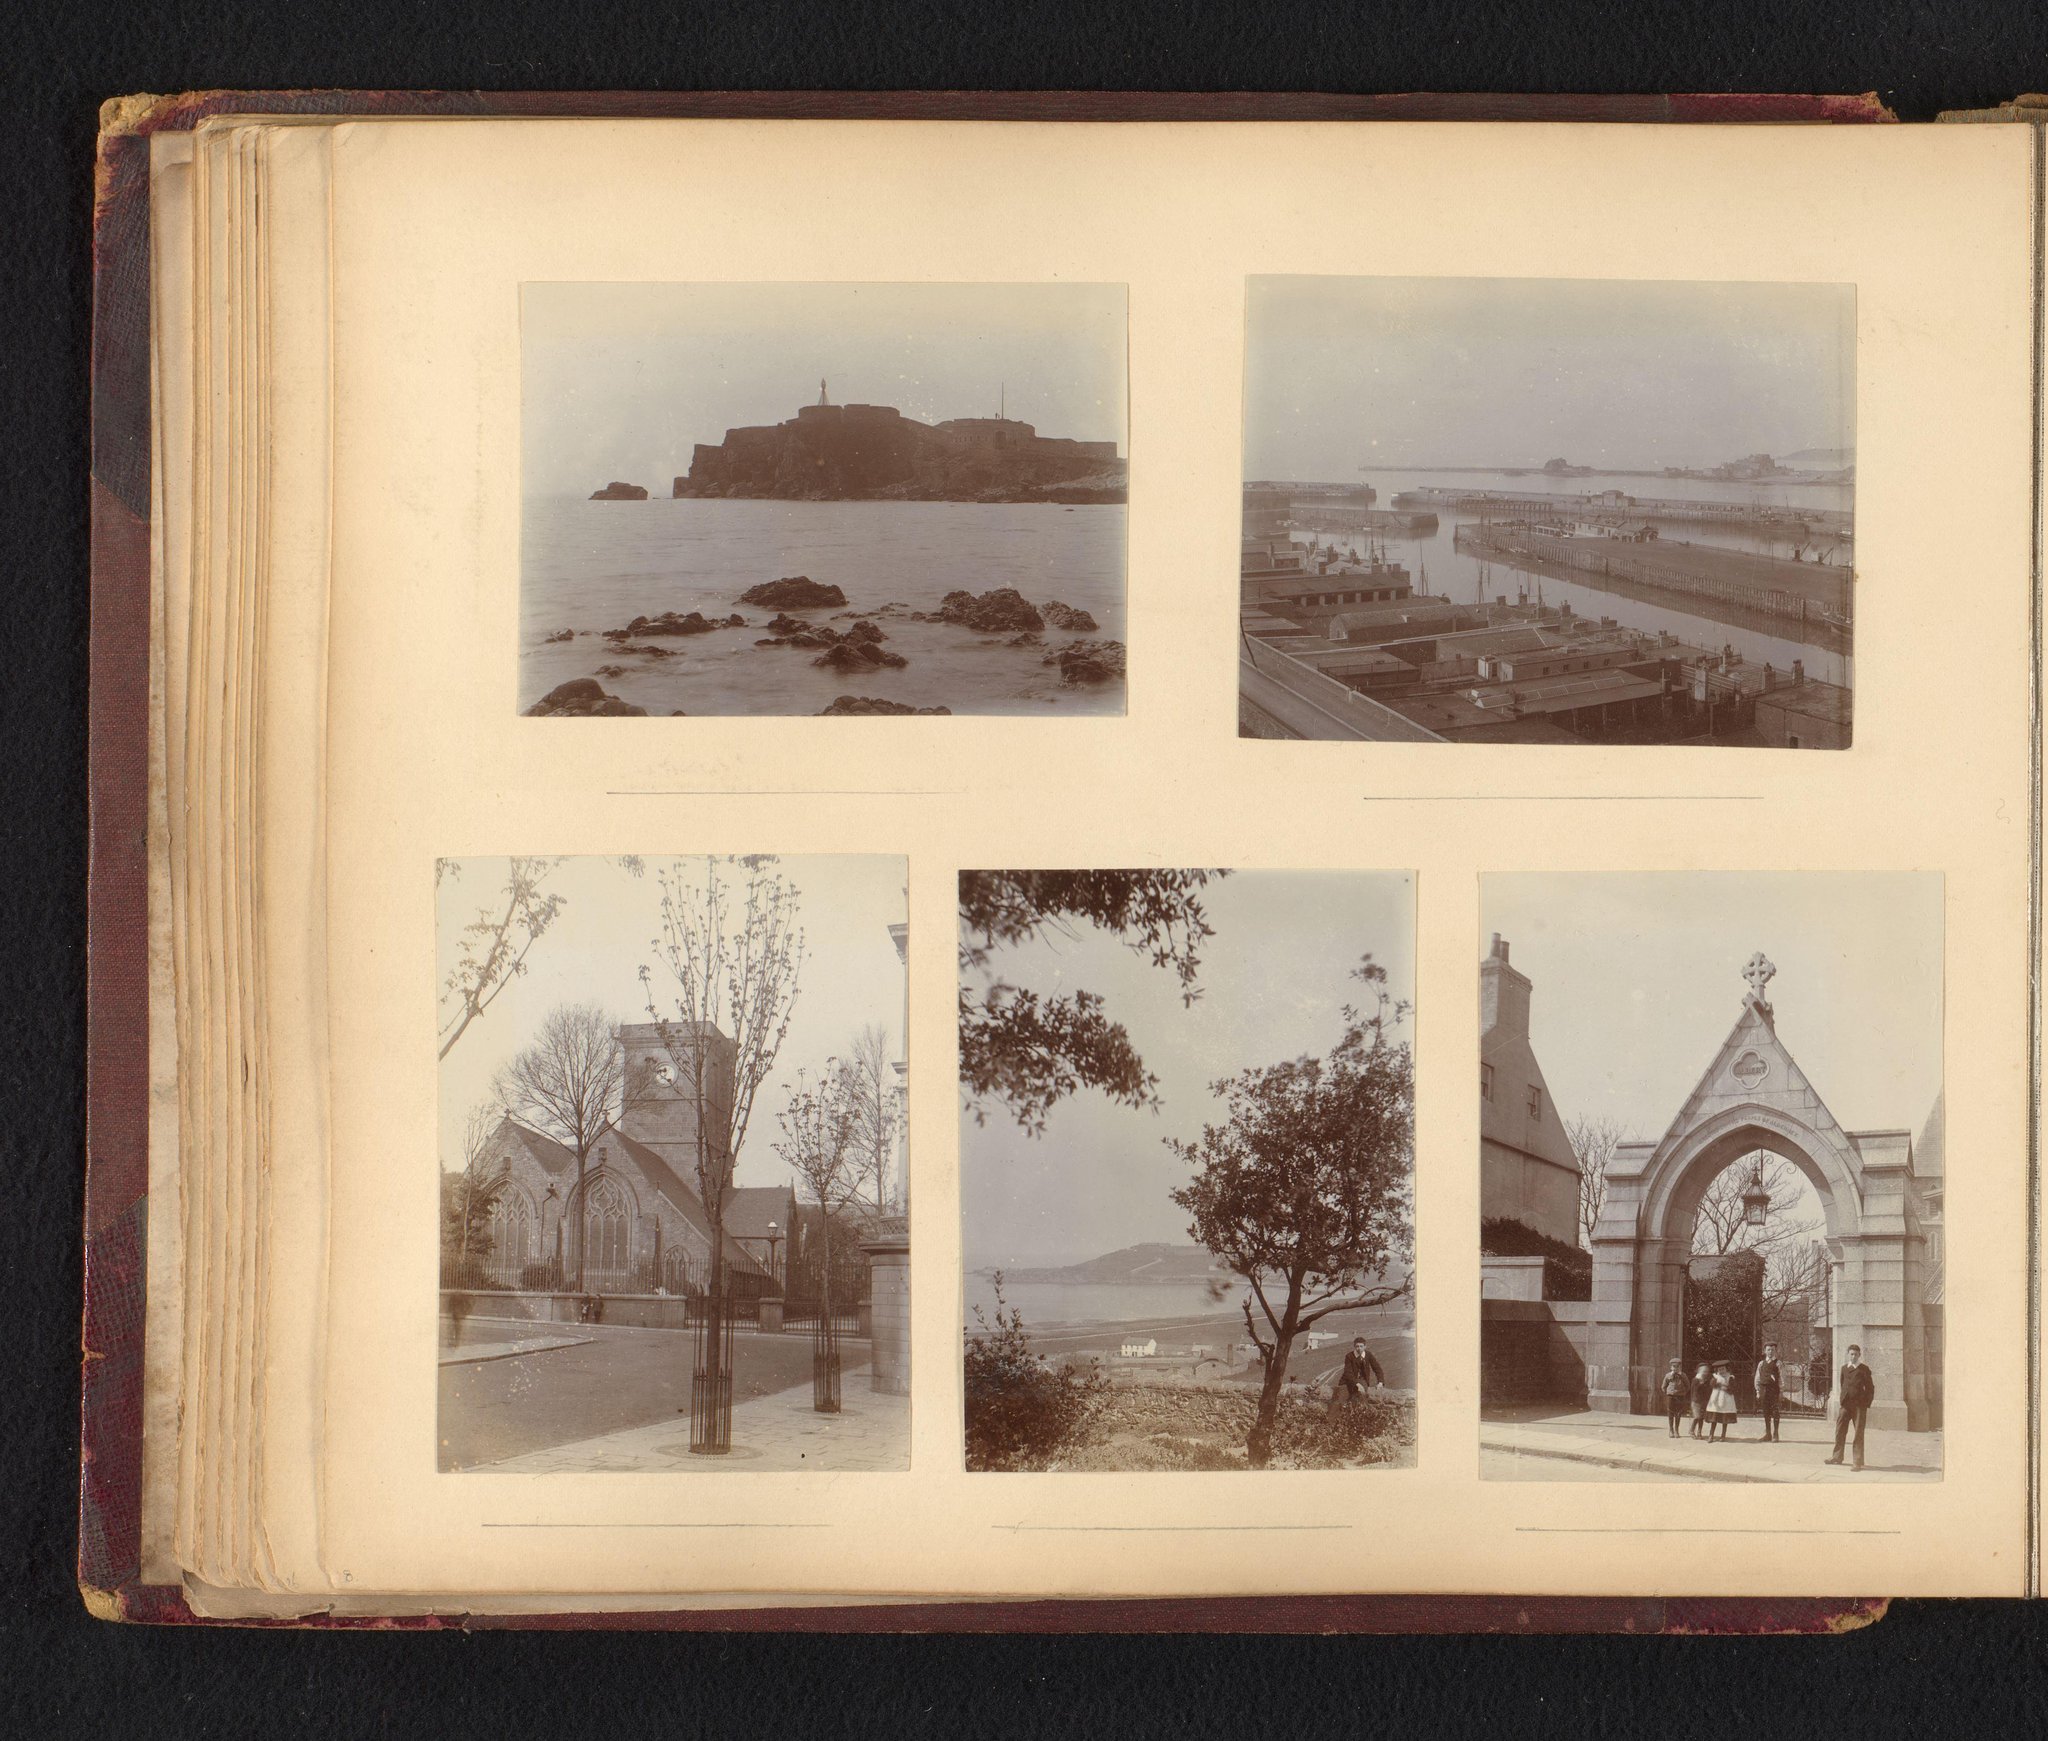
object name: photograph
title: Gezichten op Alderney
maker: Anonymous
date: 1890-1898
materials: photographic support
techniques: daylight paper print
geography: england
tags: historical persons, church (exterior), coast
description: Deze pagina maakt deel uit van een album.